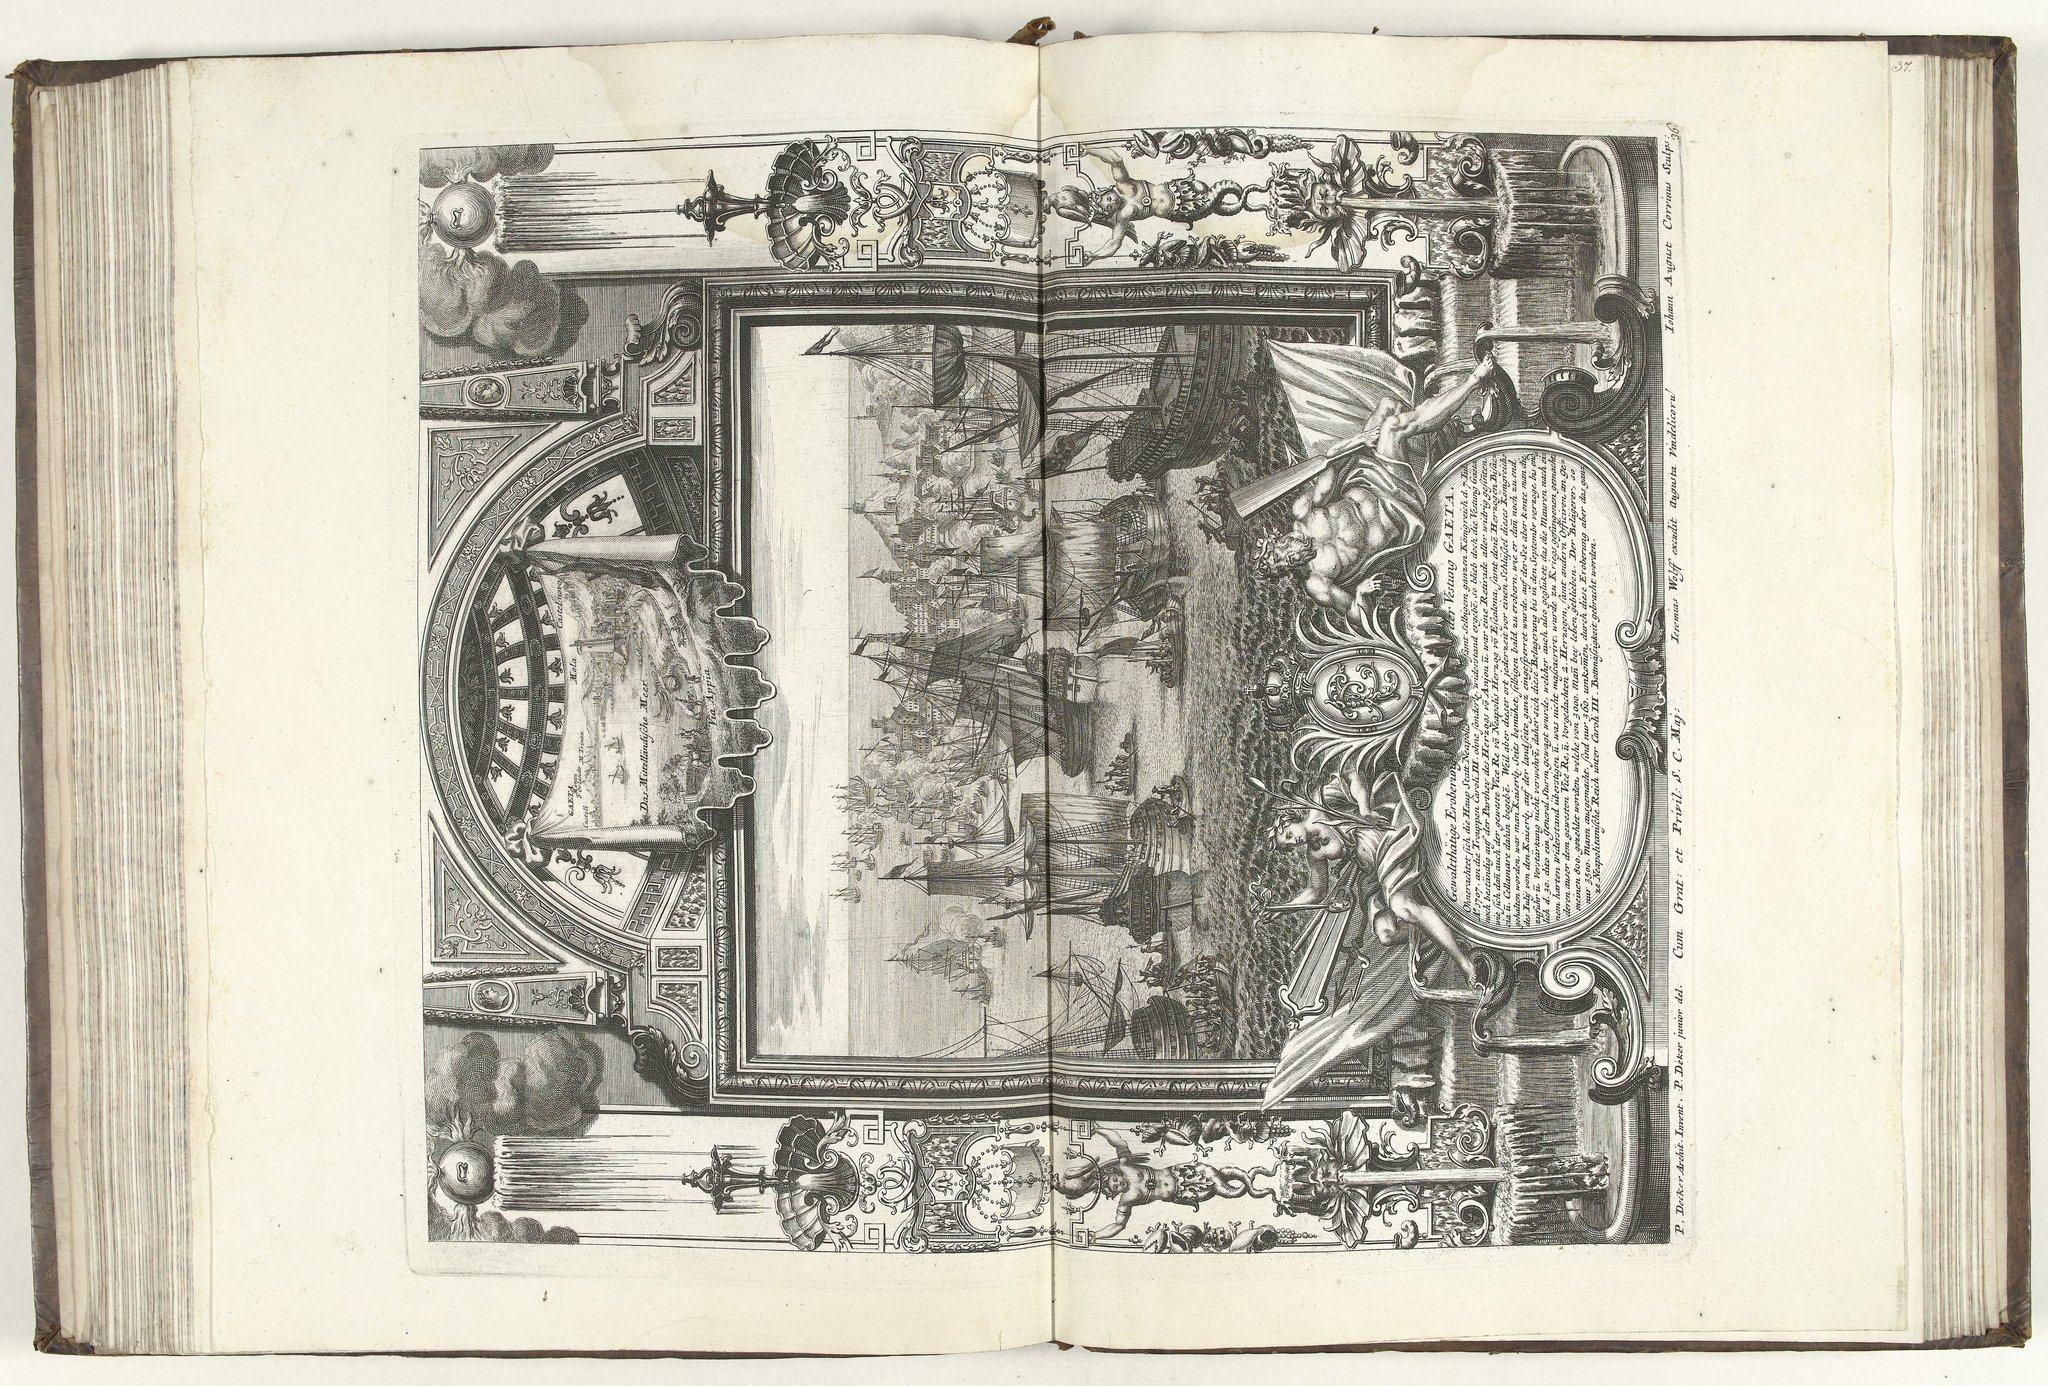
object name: print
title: Gewaltthätige Eroberung der Vestung Gaeta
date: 1712-1715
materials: paper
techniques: engraving, etching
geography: augsburg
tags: charles vi (holy roman emperor), siege, position war, battle (+ naval force)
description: De bestorming en verovering van Gaeta van de Geallieerde troepen namens koning Karel III, 30 september 1707. De centrale voorstelling van de vloot voor de stad in een rijk versierde ornamentele omlijsting met bovenaan een draperie met een gezicht op de Italiaanse kust. Onderaan een cartouche met de beschrijving van de gebeurtenissen in het Duits, bekroond door twee stroomgoden en een wapen met het monogram CR van Carolus Rex. Aan de zijkanten fonteinen met figuren. Blad in de gebonden verzameling platen uitgebracht onder de titel: Repraesentatio belli ... Der Spanische Successions-Krieg [ca. 1720].